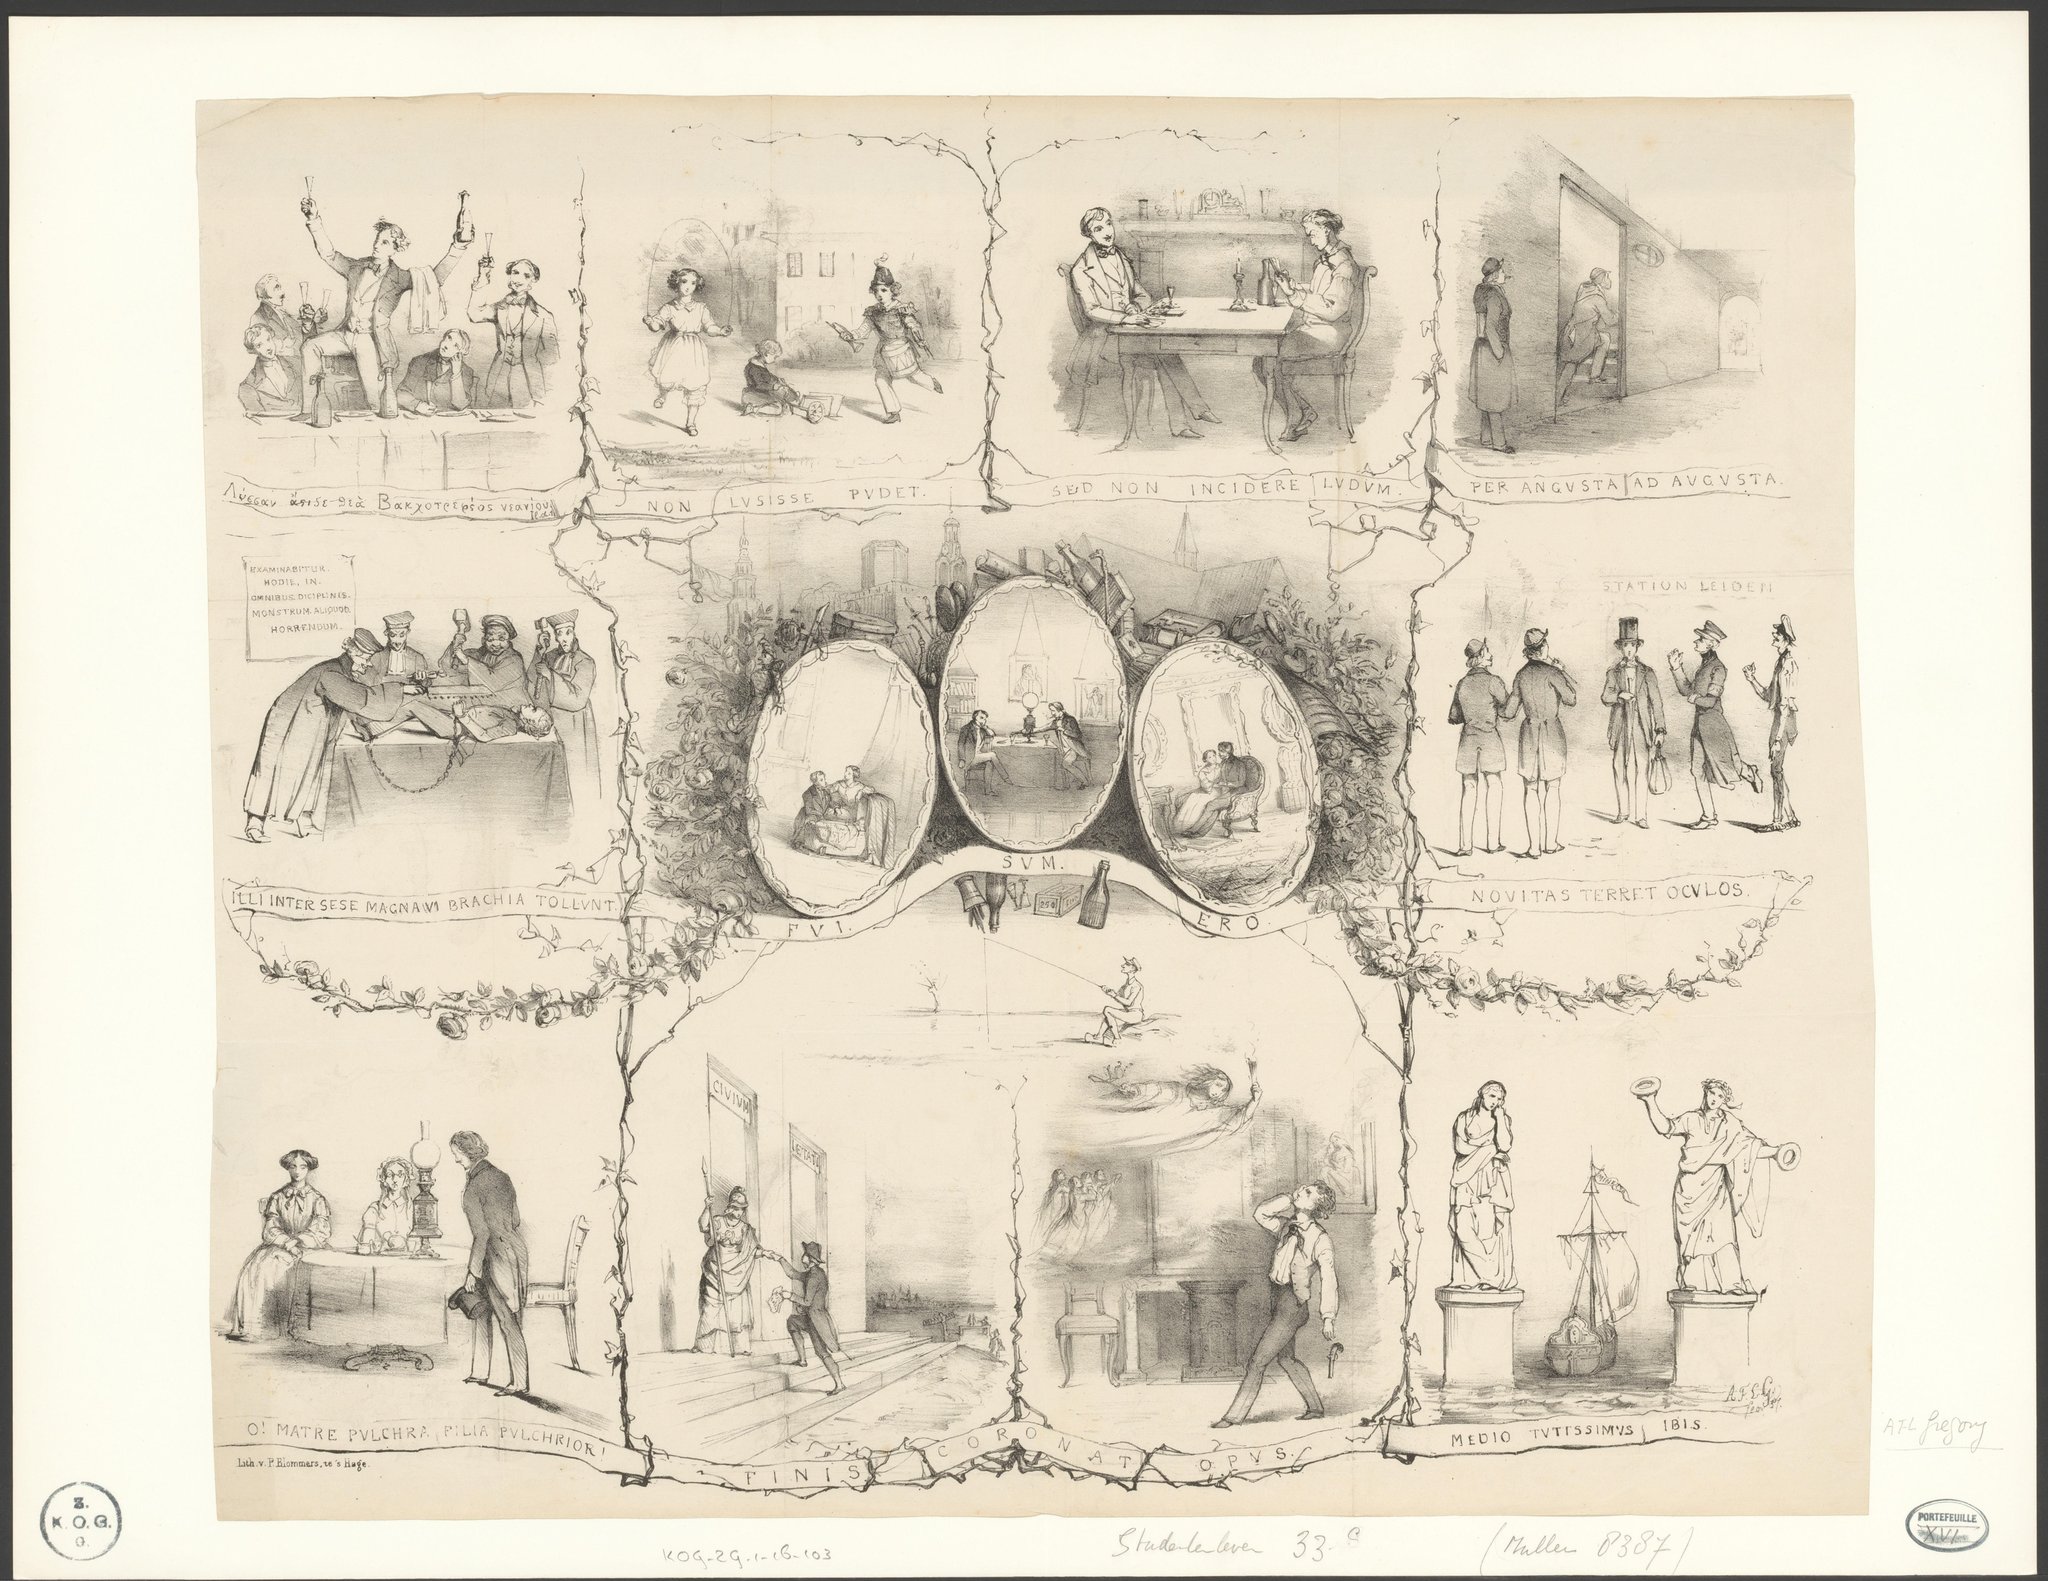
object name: cartoon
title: Studentenleven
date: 1858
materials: paper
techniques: lithograph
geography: the hague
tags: students' organization, examination ~ university, drinking, student life, leiden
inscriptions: collector's mark: Lugt 1641, stamp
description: Dertien voorstellingen uit het studentenleven. Onderwerpsrubrieken binnen de Atlas Zeden en Gewoonten: Onderwijs en Wetenschappen, Studentenleven.